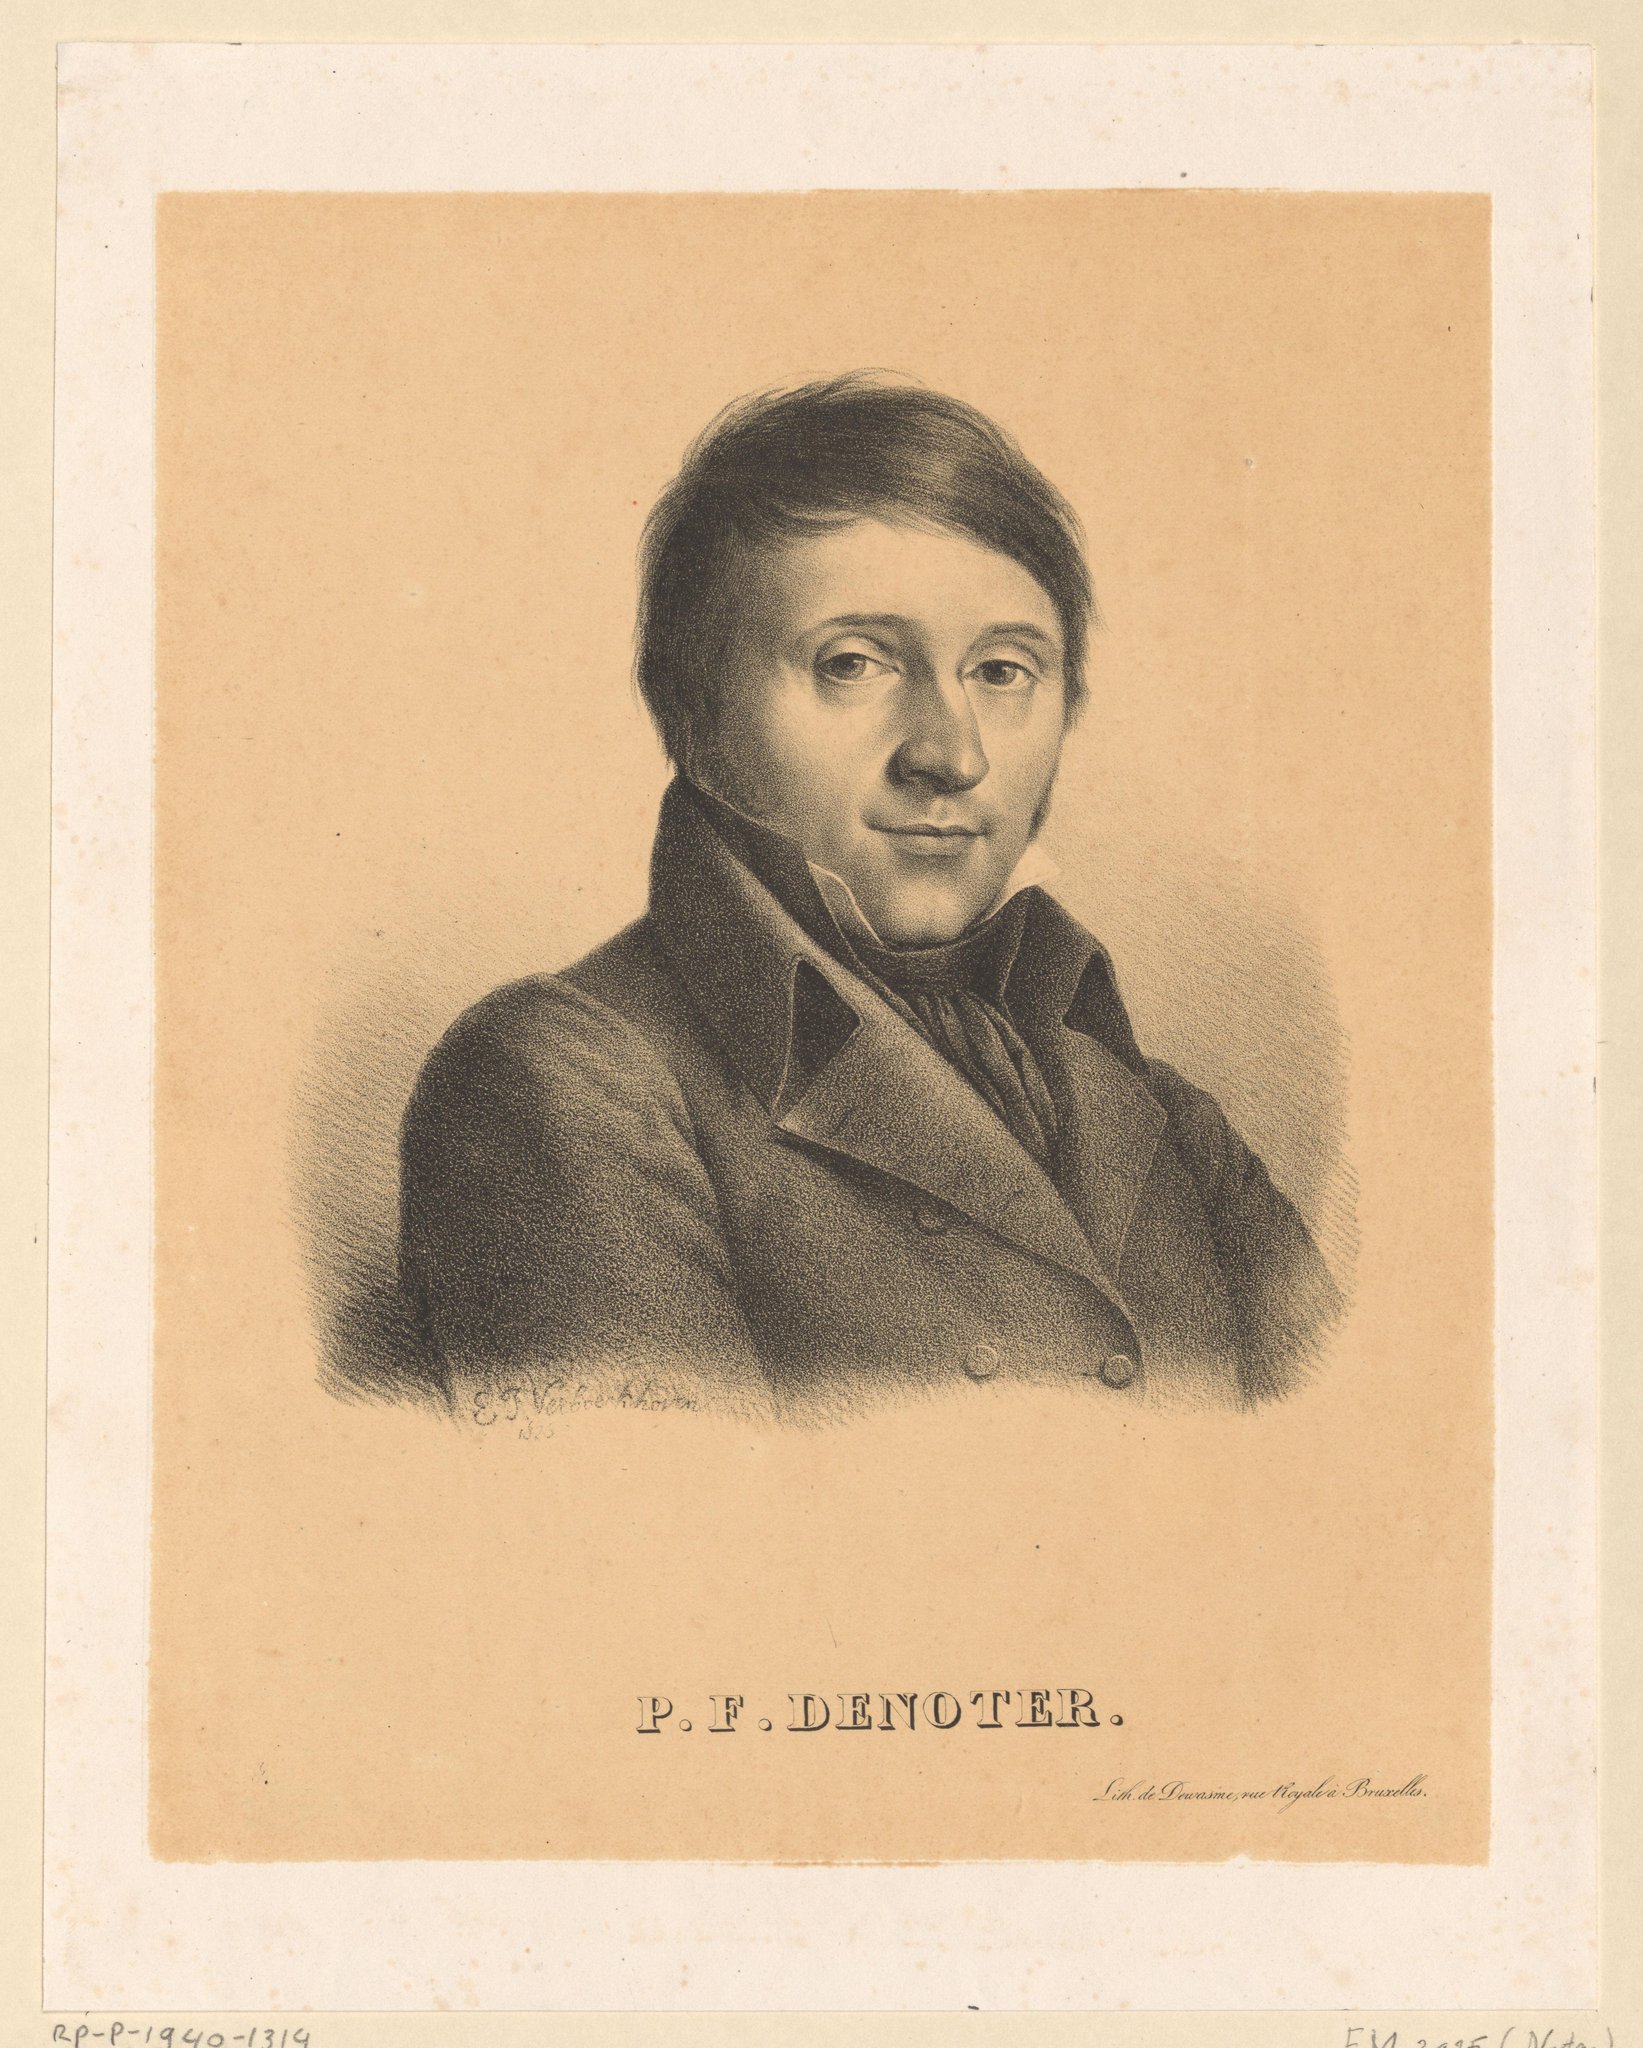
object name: print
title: Portret van Pierre François De Noter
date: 1826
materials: paper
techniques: tone lithography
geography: brussels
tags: ghent, painter, print maker, pierre françois de noter, historical persons, portrait, self-portrait of painter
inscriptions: collector's mark: Lugt 2228, collector's mark: Lugt 2760